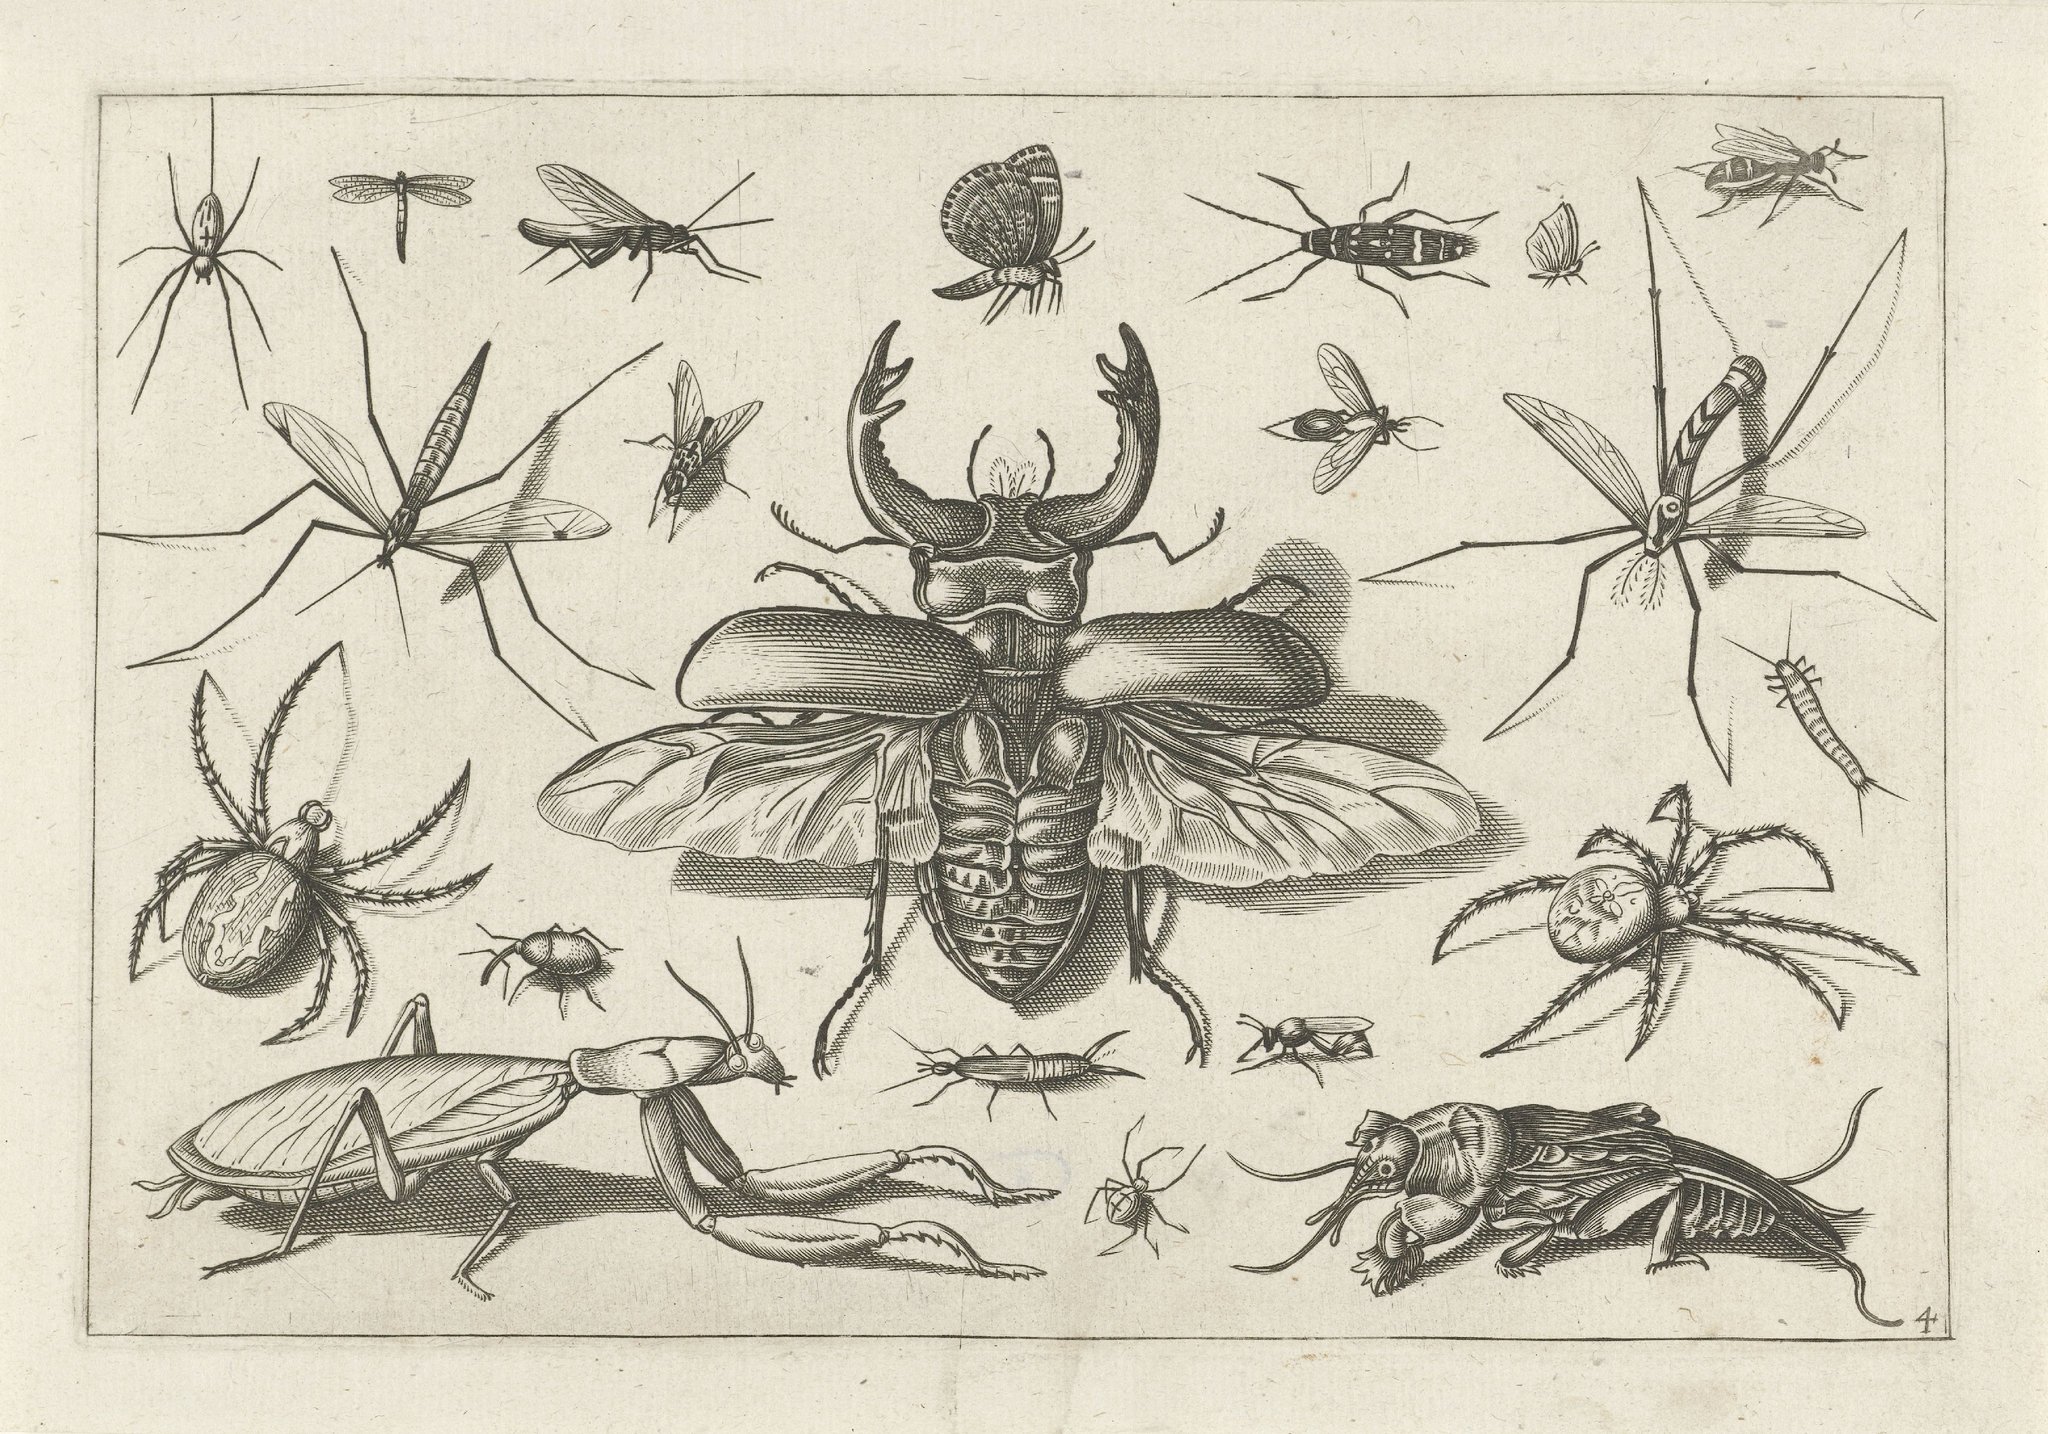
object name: print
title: Diversae Insectarum Volatilium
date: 1630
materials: paper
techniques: engraving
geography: low countries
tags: insects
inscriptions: collector's mark: Lugt 2228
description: Diverse insecten met in het midden een hertkever.